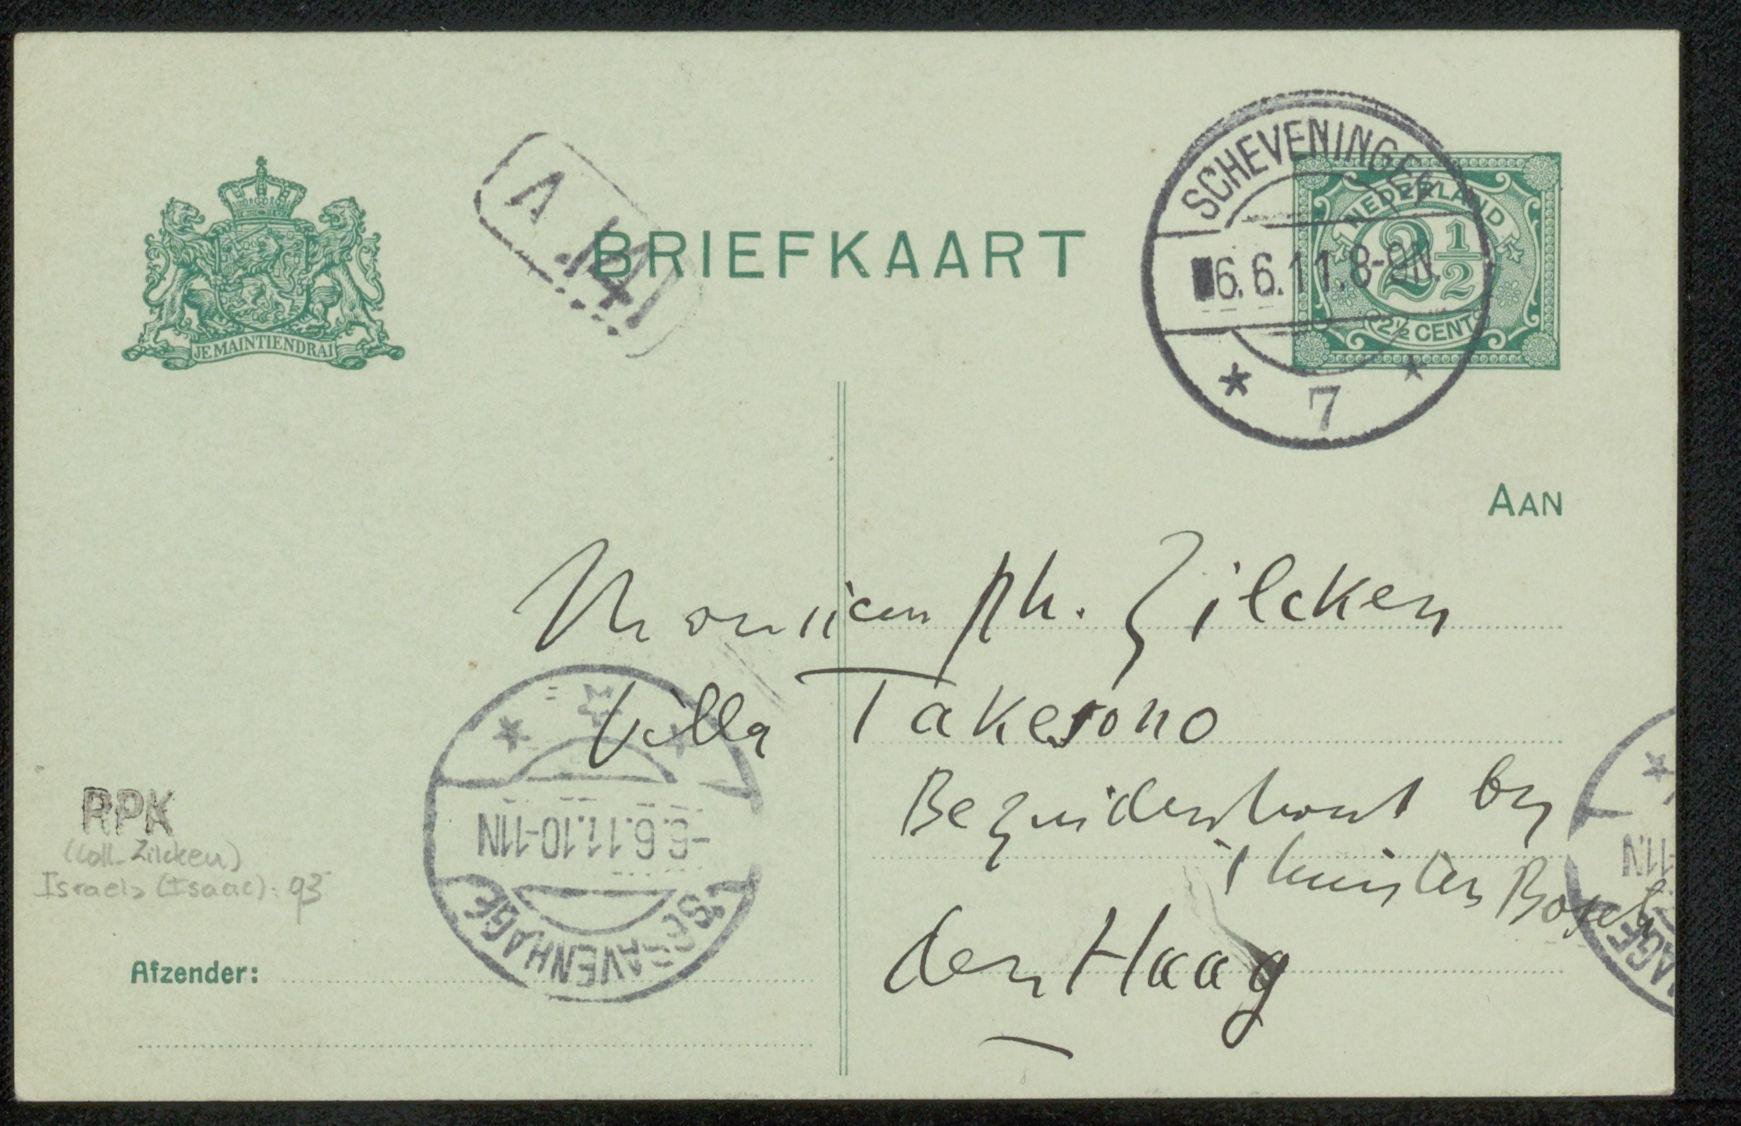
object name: postcard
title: Briefkaart aan Philip Zilcken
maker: isaac israels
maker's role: draughtsman, painter, print maker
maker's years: 1865-1934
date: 1911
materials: cardboard, ink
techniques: writing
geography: scheveningen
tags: philip zilcken, drawing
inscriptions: collector's mark: ‘RPK’